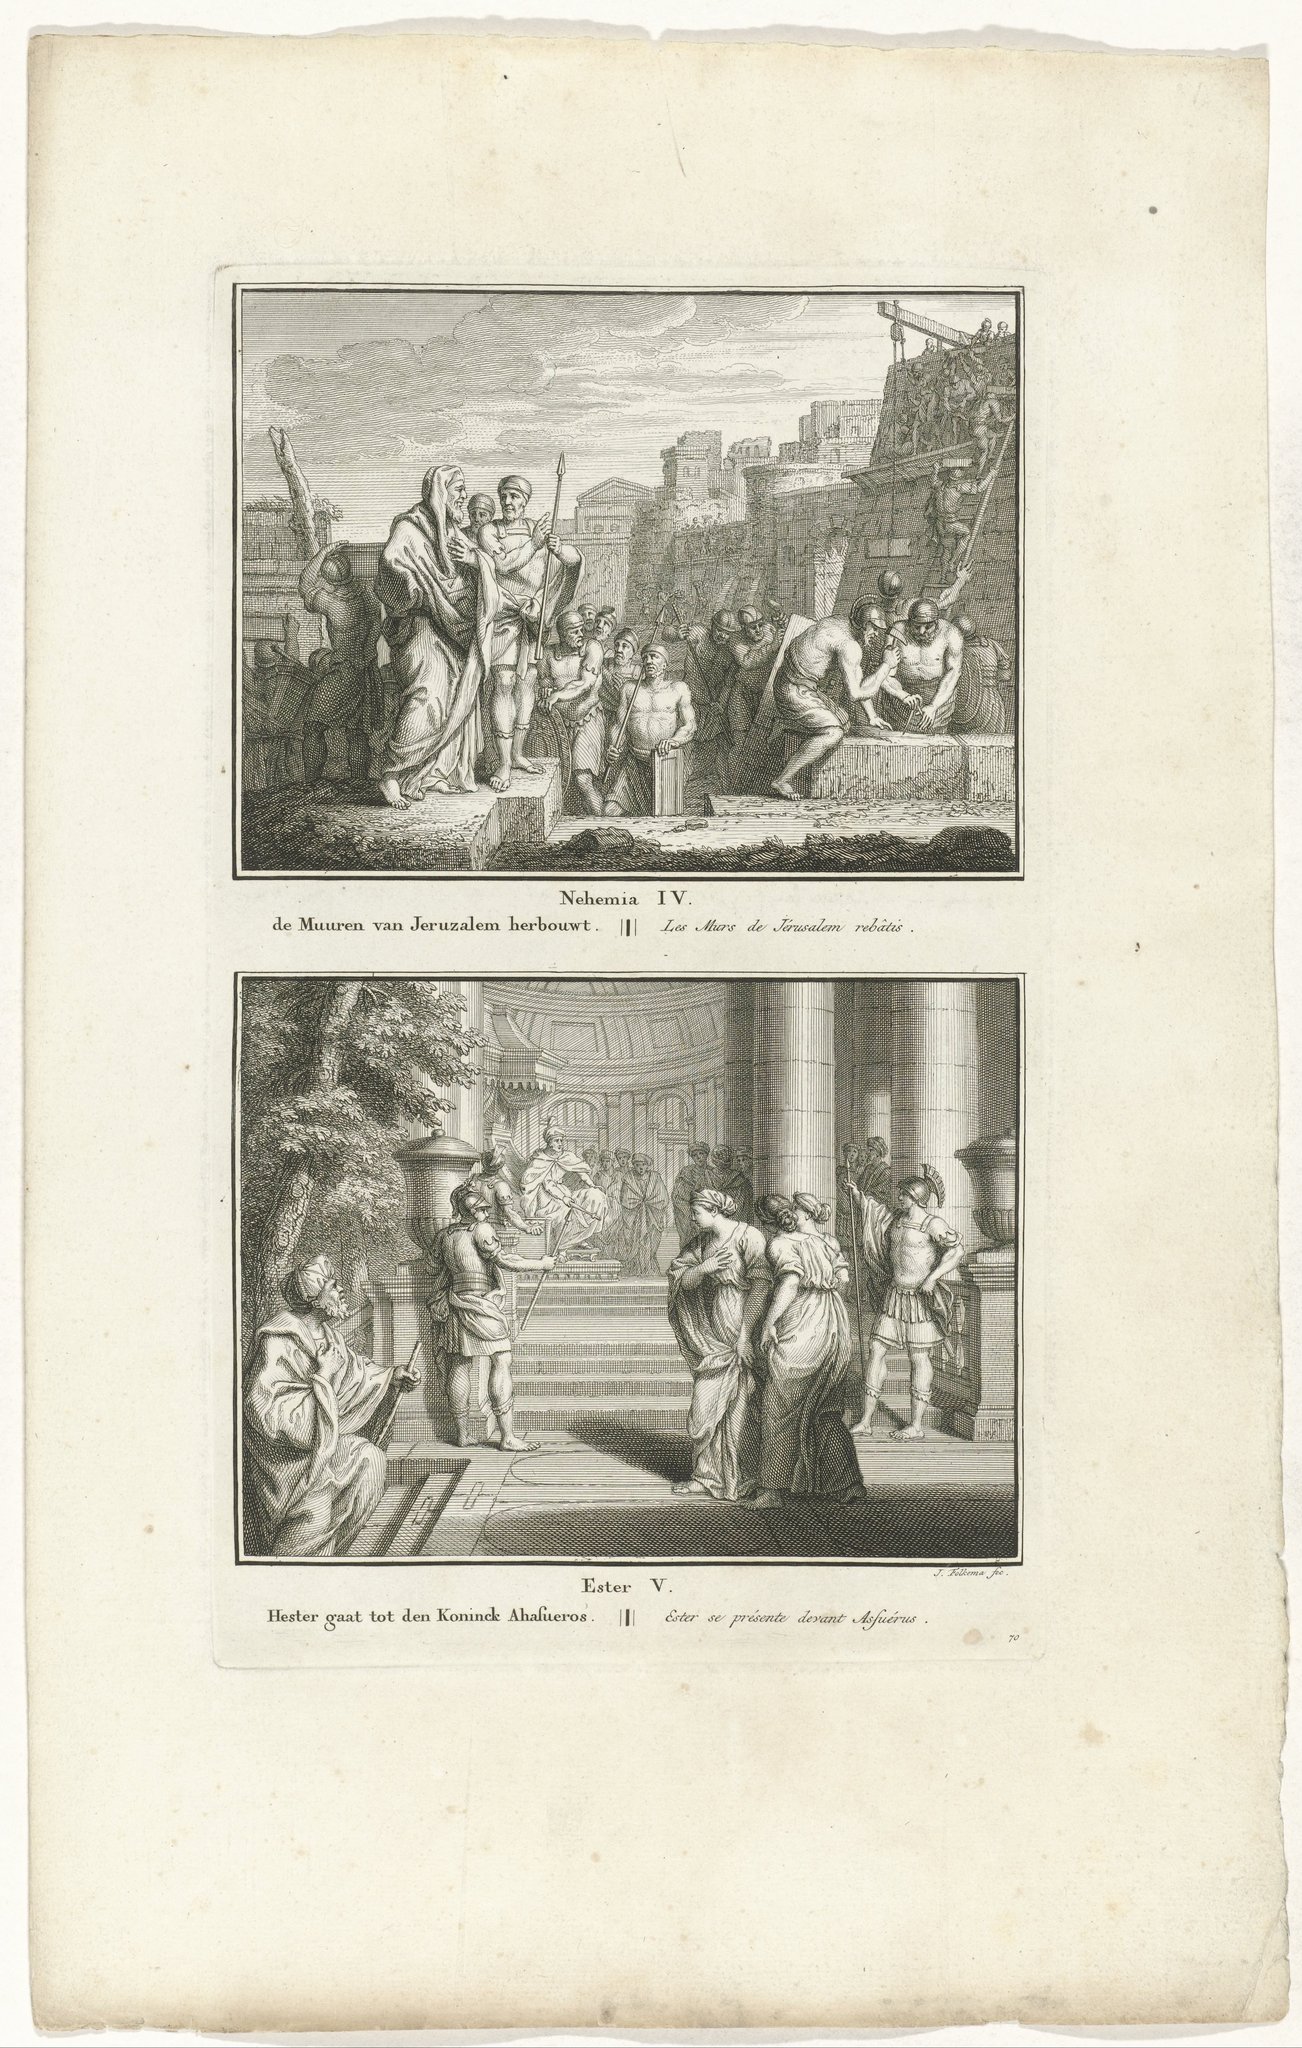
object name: print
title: Herbouw van de muren van Jeruzalem en Esther bezoekt koning Ahasveros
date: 1791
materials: paper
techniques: etching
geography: amsterdam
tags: esther before ahasuerus (esther 5:1-4), the rebuilding of jerusalem's walls (nehemiah 2:12 - 4; 6)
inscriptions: collector's mark: Lugt 2233, collector's mark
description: Illustratie uit: Hamelsveld, Ysbrand van. De gewigtigste geschiedenissen des Bybels, afgebeeld in twee honderd twee en vijftig printverbeeldingen (...) met eene zaaklijke uitbreiding opgehelderd. Amsterdam / Dordrecht: Jan de Groot / Abraham en Pieter Blussé.